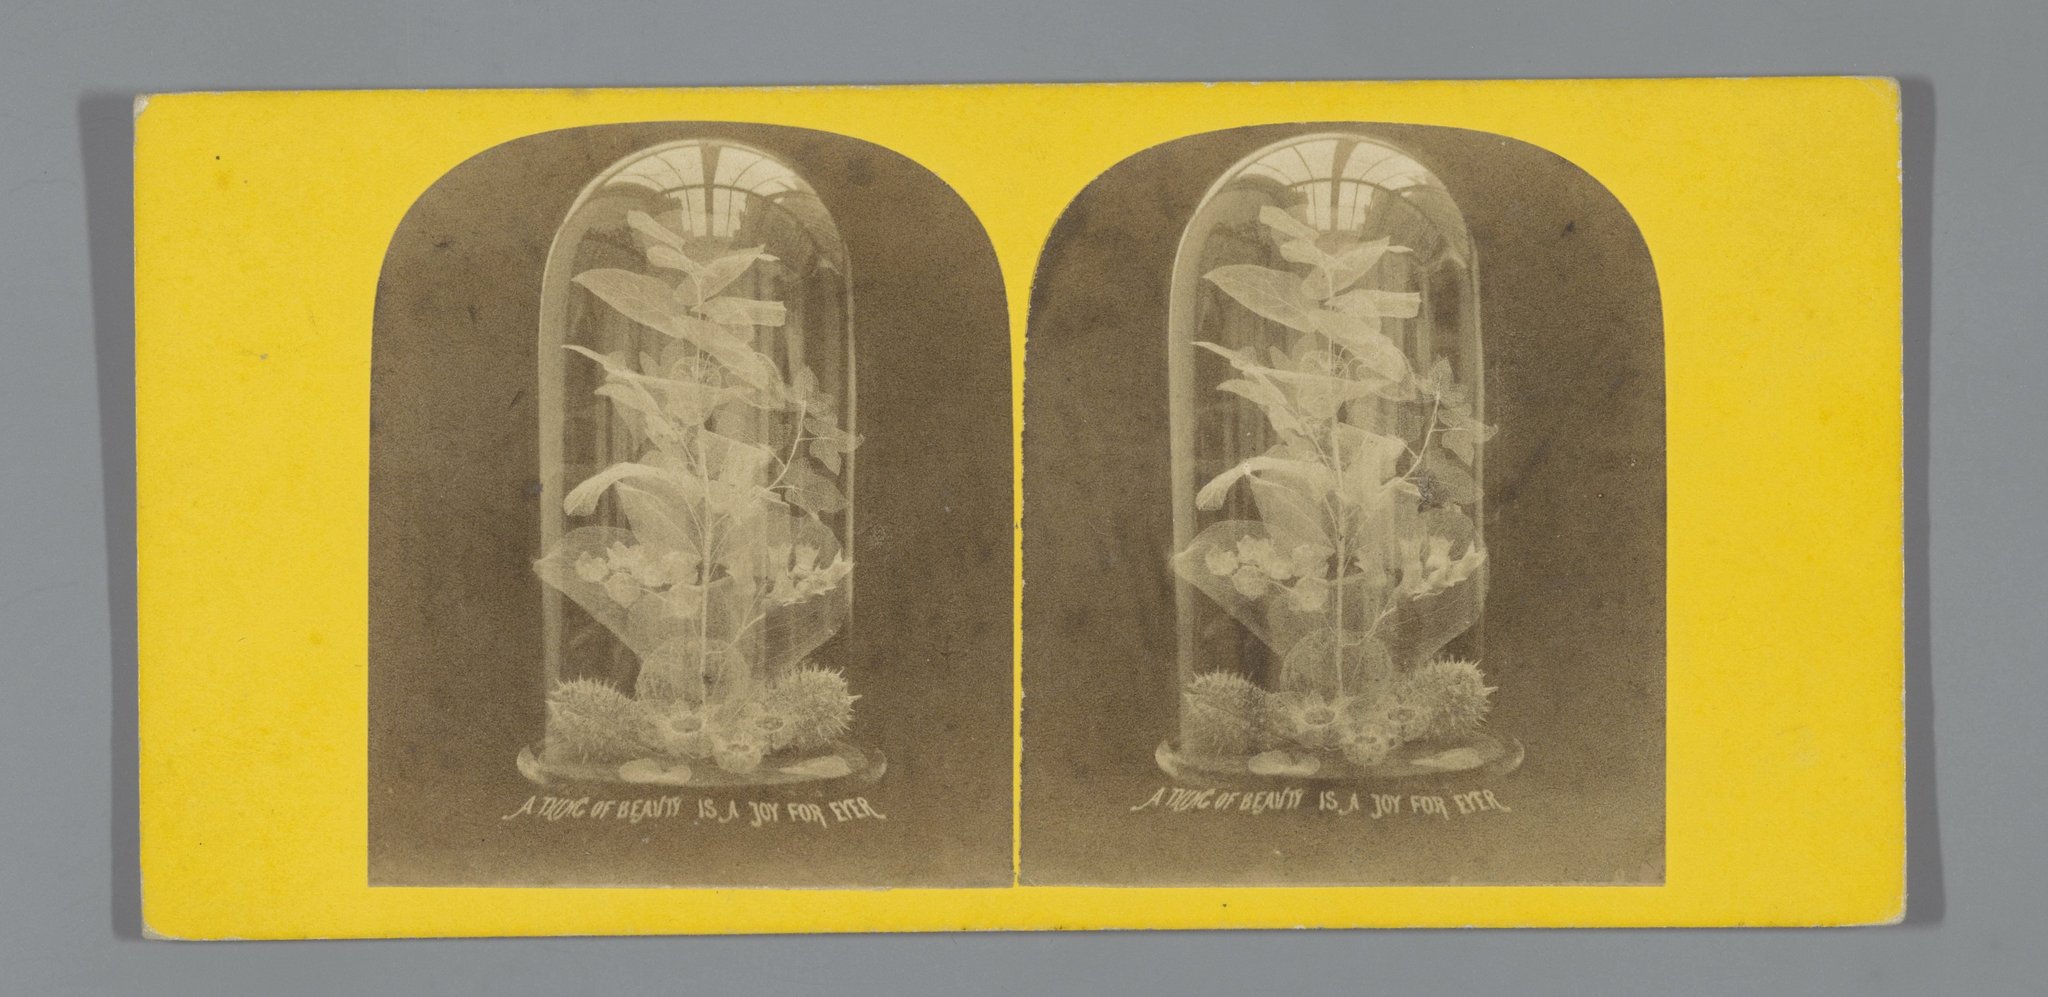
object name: stereograph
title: A Thing of Beauty is a Joy For Ever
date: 1858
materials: cardboard, photographic support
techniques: albumen print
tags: dried flowers, glass bell, glass cover ~ horticulture, still life of miscellaneous objects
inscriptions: label: ‘Kalverstraat / bij de Heiligenweg D133’, number: ‘104’, number: ‘307’